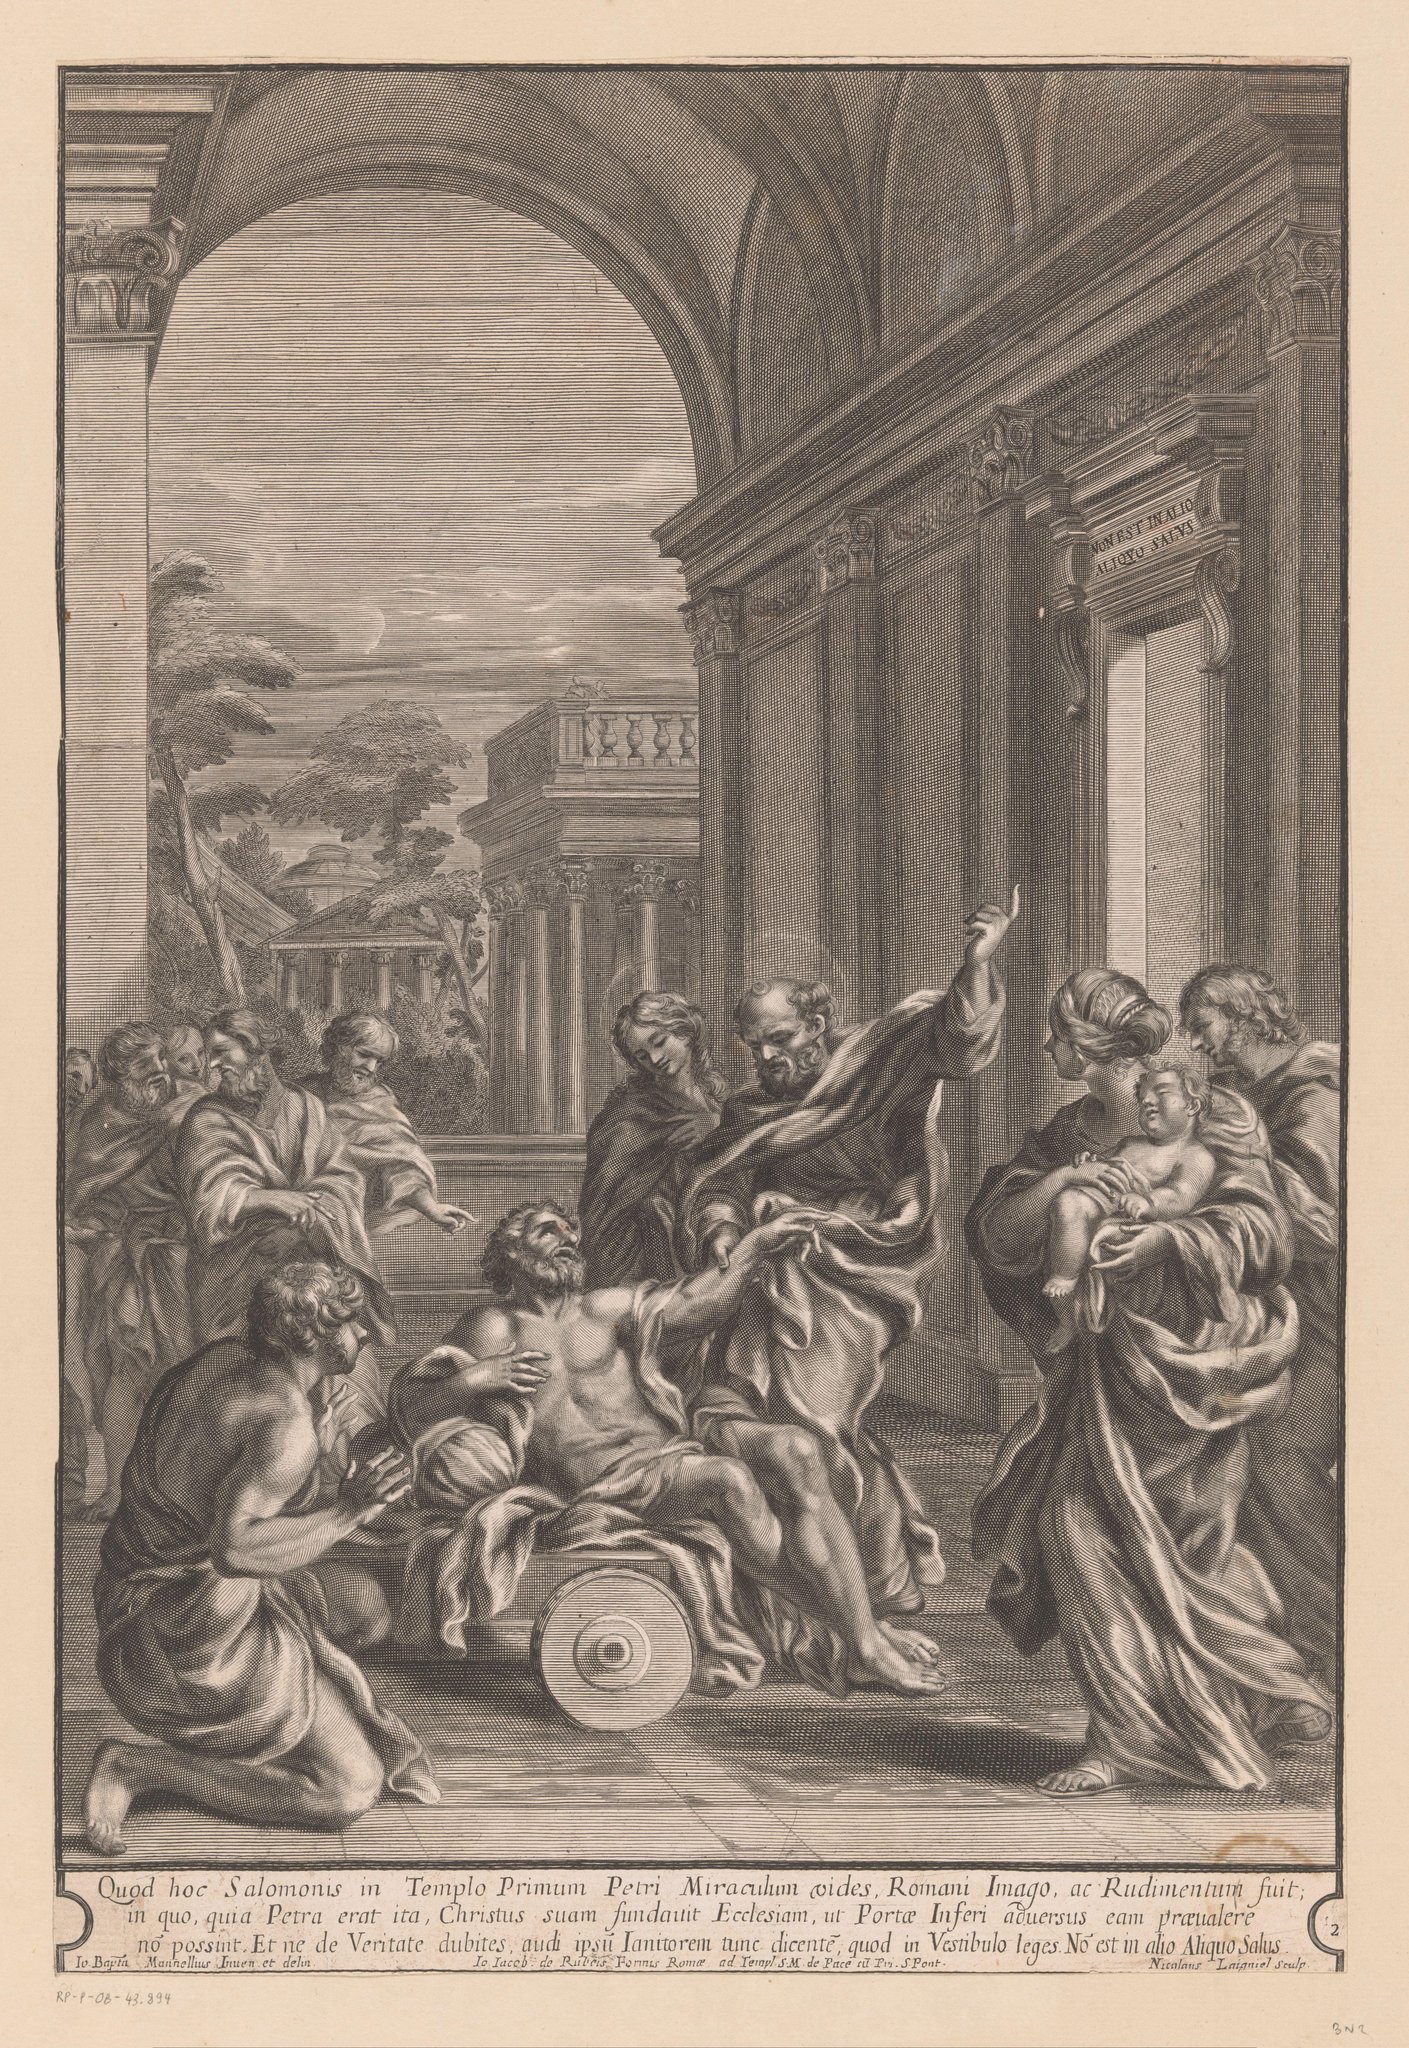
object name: print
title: Wonder van Petrus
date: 1670-1691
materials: paper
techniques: engraving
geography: rome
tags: healing of a lame beggar at the beautiful gate of the temple by peter and john (acts 3 - 4:31)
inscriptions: collector's mark: Lugt 240